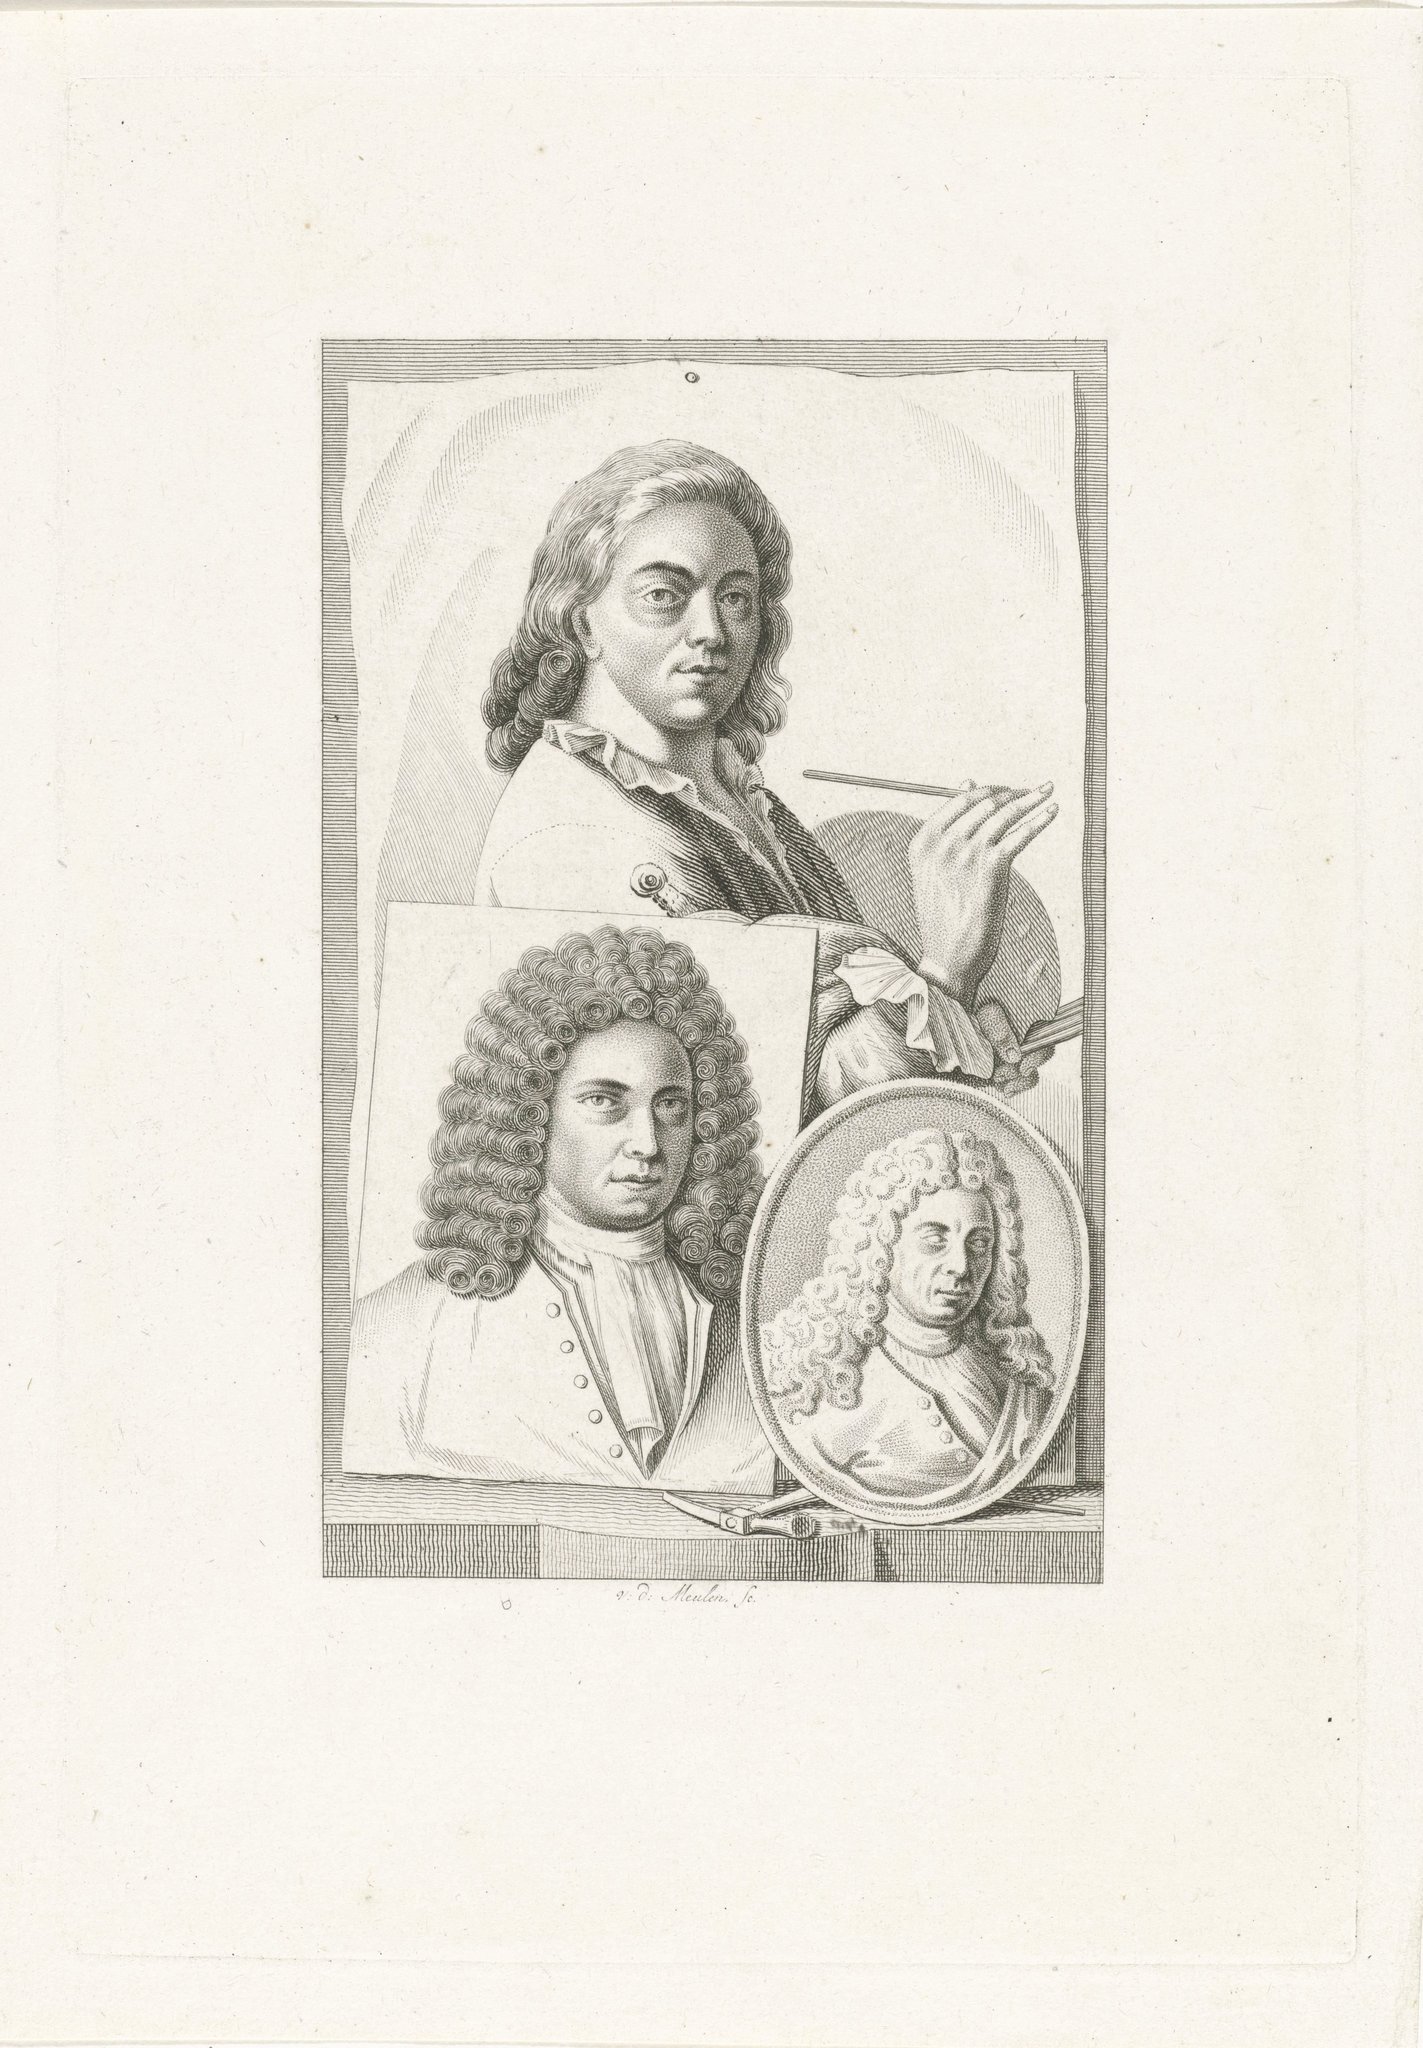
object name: print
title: Portretten van N.N. Roukens, Hendrik Soukens en Frans van Eynden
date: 1816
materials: paper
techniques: engraving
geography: amsterdam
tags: nijmegen, painter, draughtsman, hendrik soukens, portrait, self-portrait of artist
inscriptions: collector's mark: Lugt 2228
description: Op de achtergrond het portret van kunstenaar Hendrik Soukens met een palet en penseel in de hand. Daartegen het portret van kunstenaar Frans van Eynden. Daarnaast in een ovale lijst het portret van metaalgraveur, tekenaar en beeldhouwer N.N. Roukens.